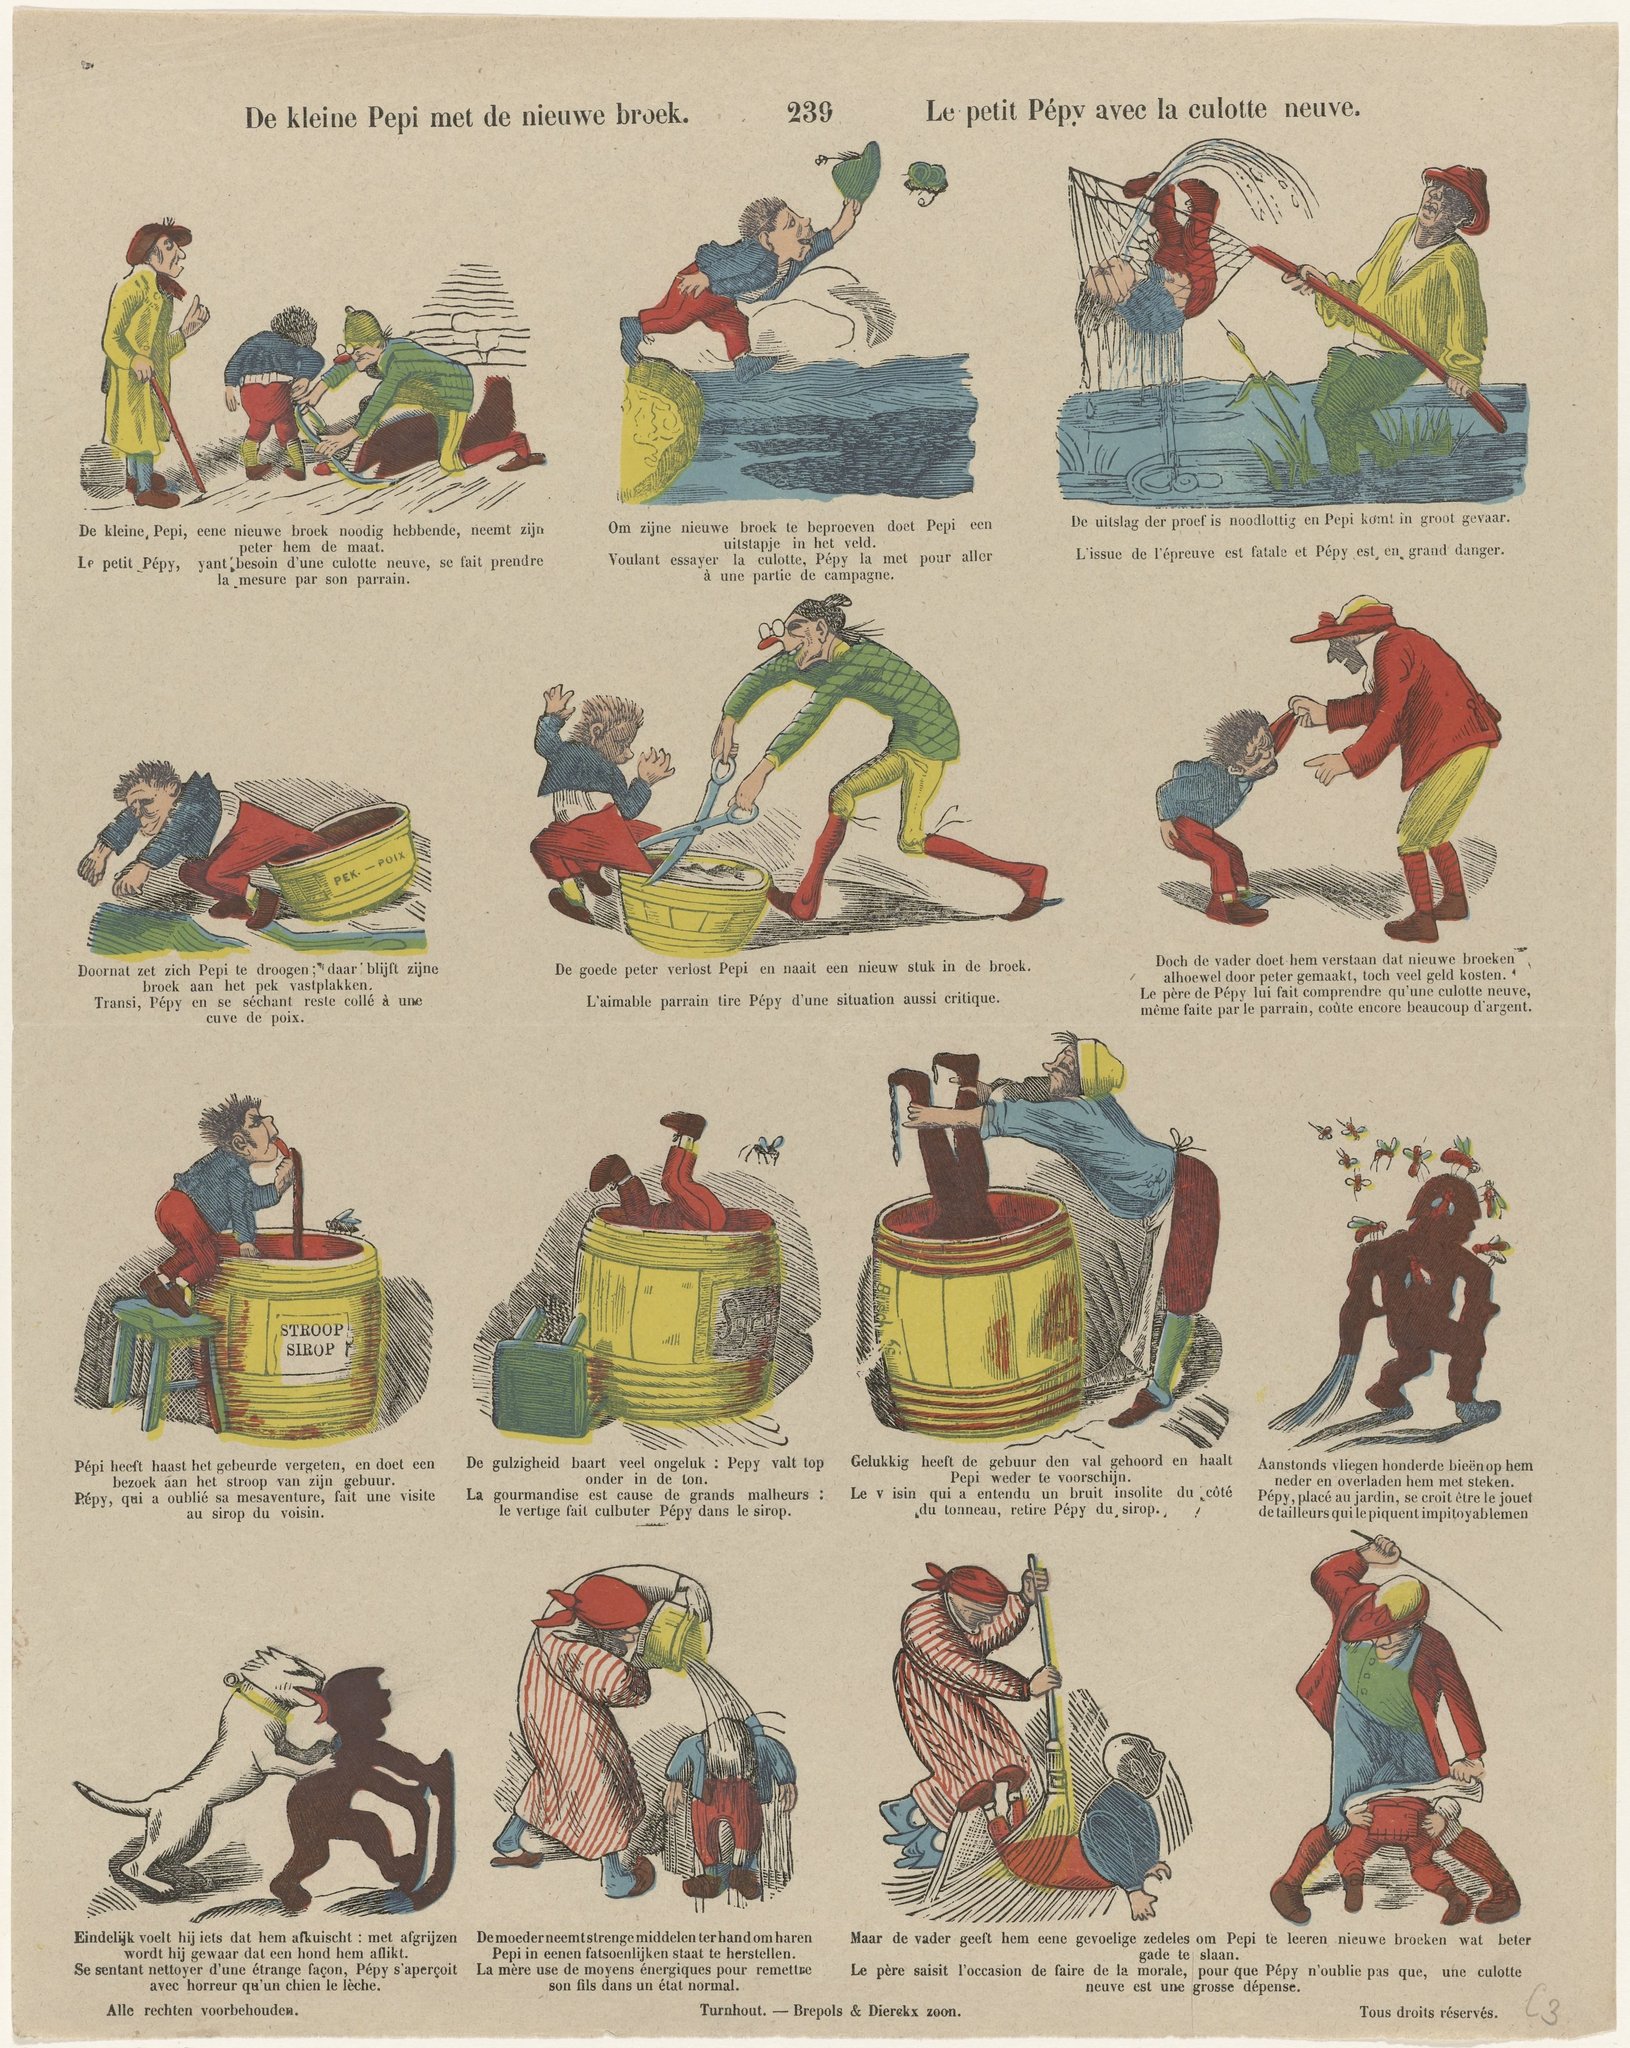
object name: popular print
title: De kleine Pepi met de nieuwe broek / Le petit Pépy avec la culotte neuve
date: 1833-1911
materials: paper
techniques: lithograph, letterpress printing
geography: turnhout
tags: mischief-making play, correction of naughty children, trousers, breeches, bad behaviour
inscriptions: collector's mark: Lugt 2760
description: Blad met 14 voorstellingen over Pepi die met zijn nieuwe broek allerlei kattenkwaad uithaalt en een pak slaag krijgt. Onder elke afbeelding een onderschrift in het Nederlands en in het Frans. Genummerd midden boven: 239.